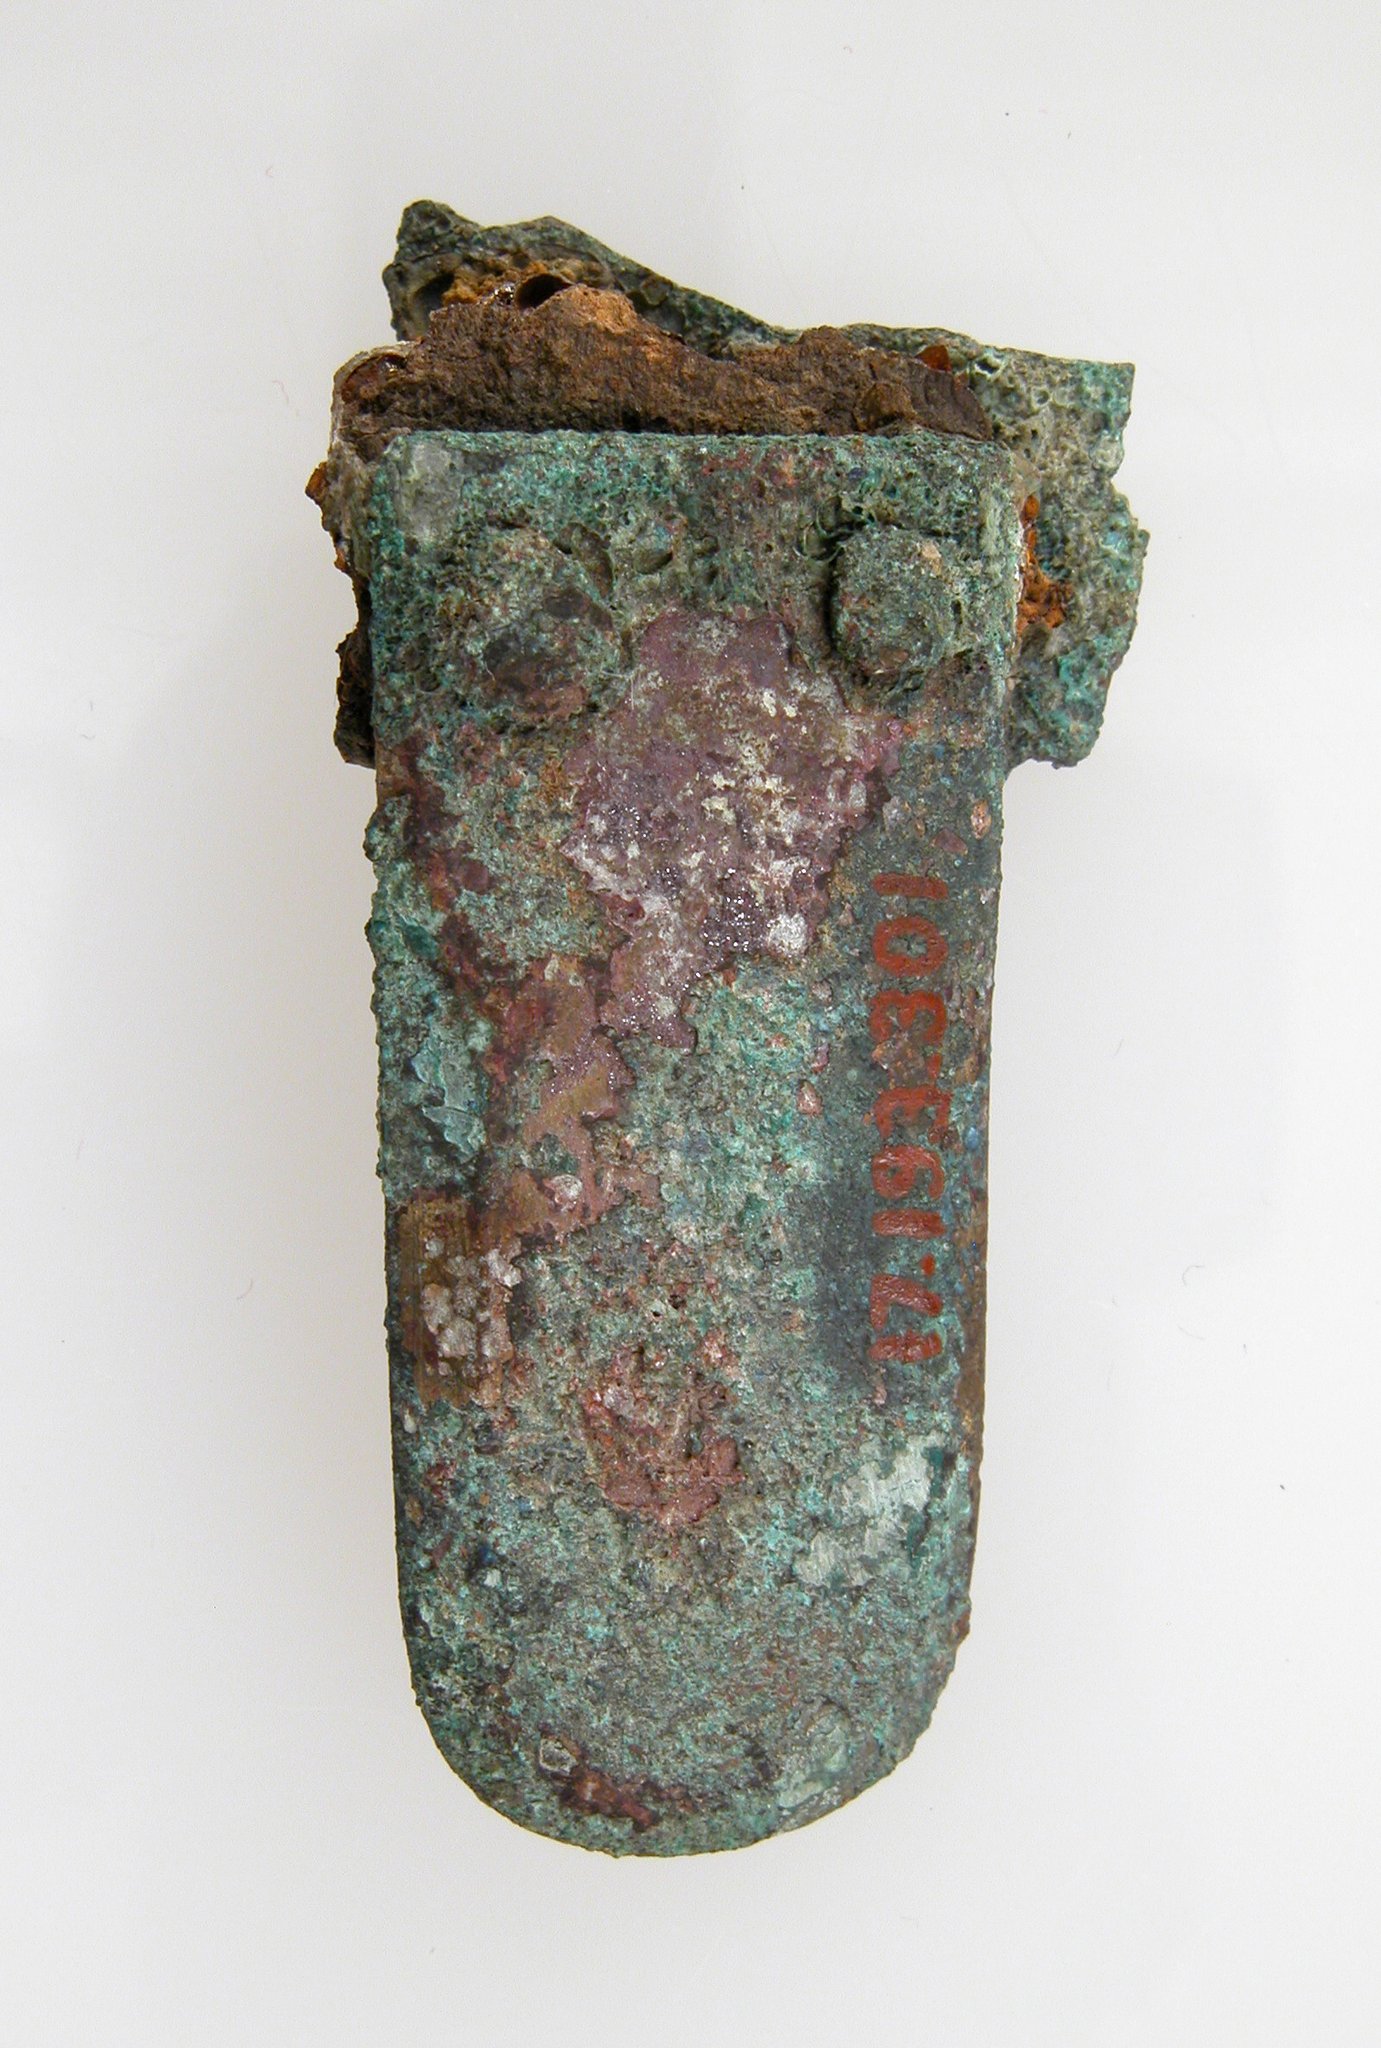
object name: ferret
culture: frankish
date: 601-700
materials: copper alloy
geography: germany